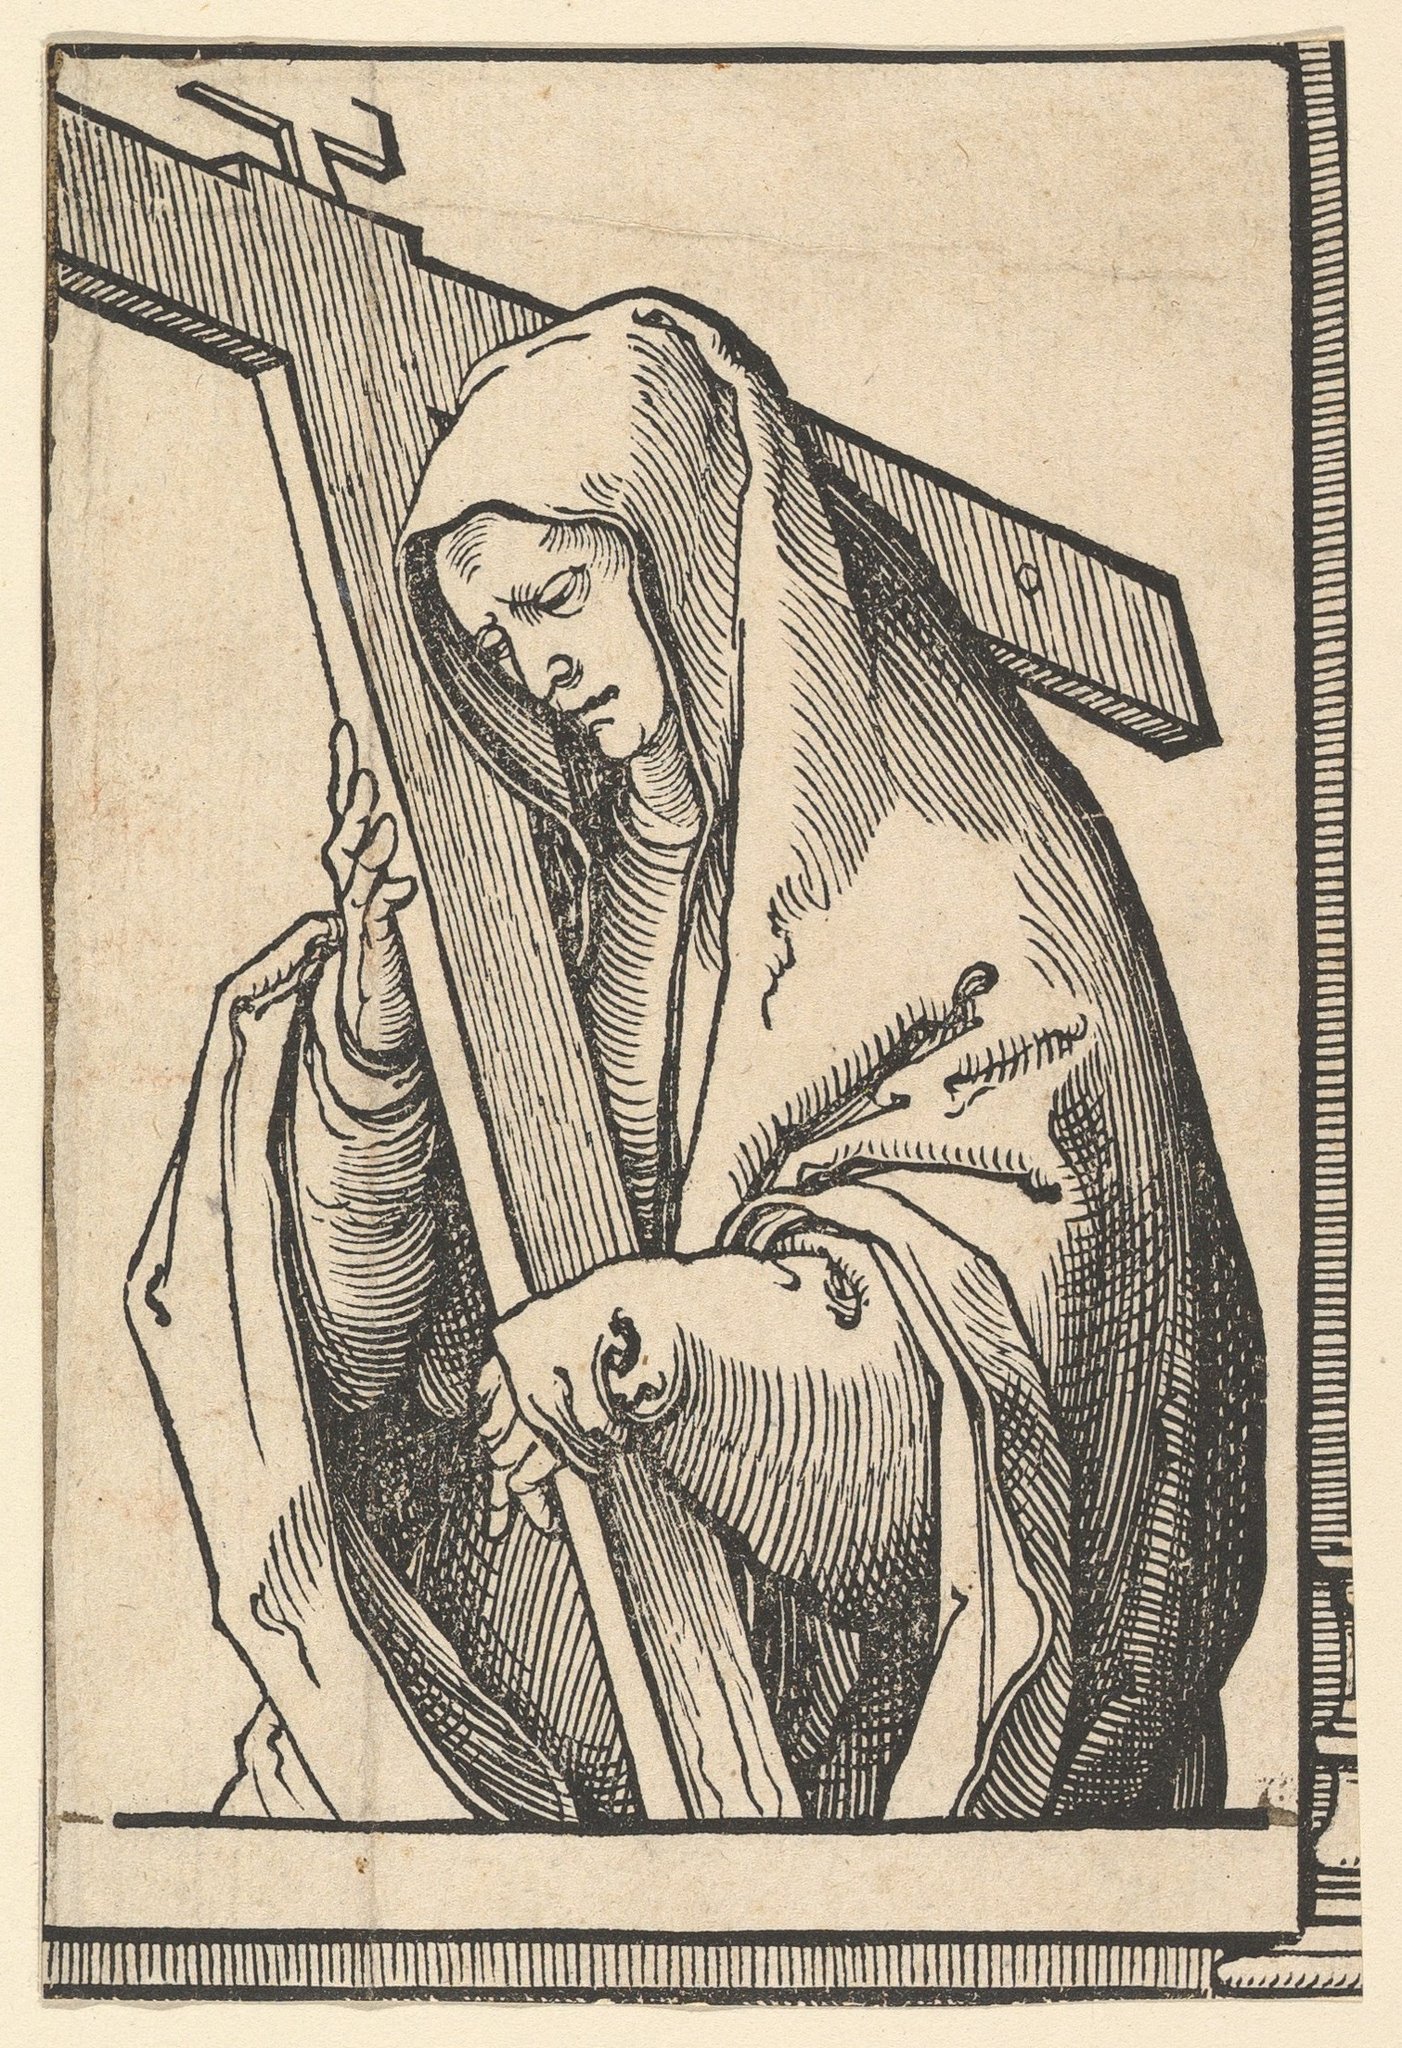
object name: print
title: Helleoportic Sibyl, from the series of Sibyls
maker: lucas van leyden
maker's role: artist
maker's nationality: netherlandish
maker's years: 1494-1533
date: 1530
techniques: woodcut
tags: sibyl,cross